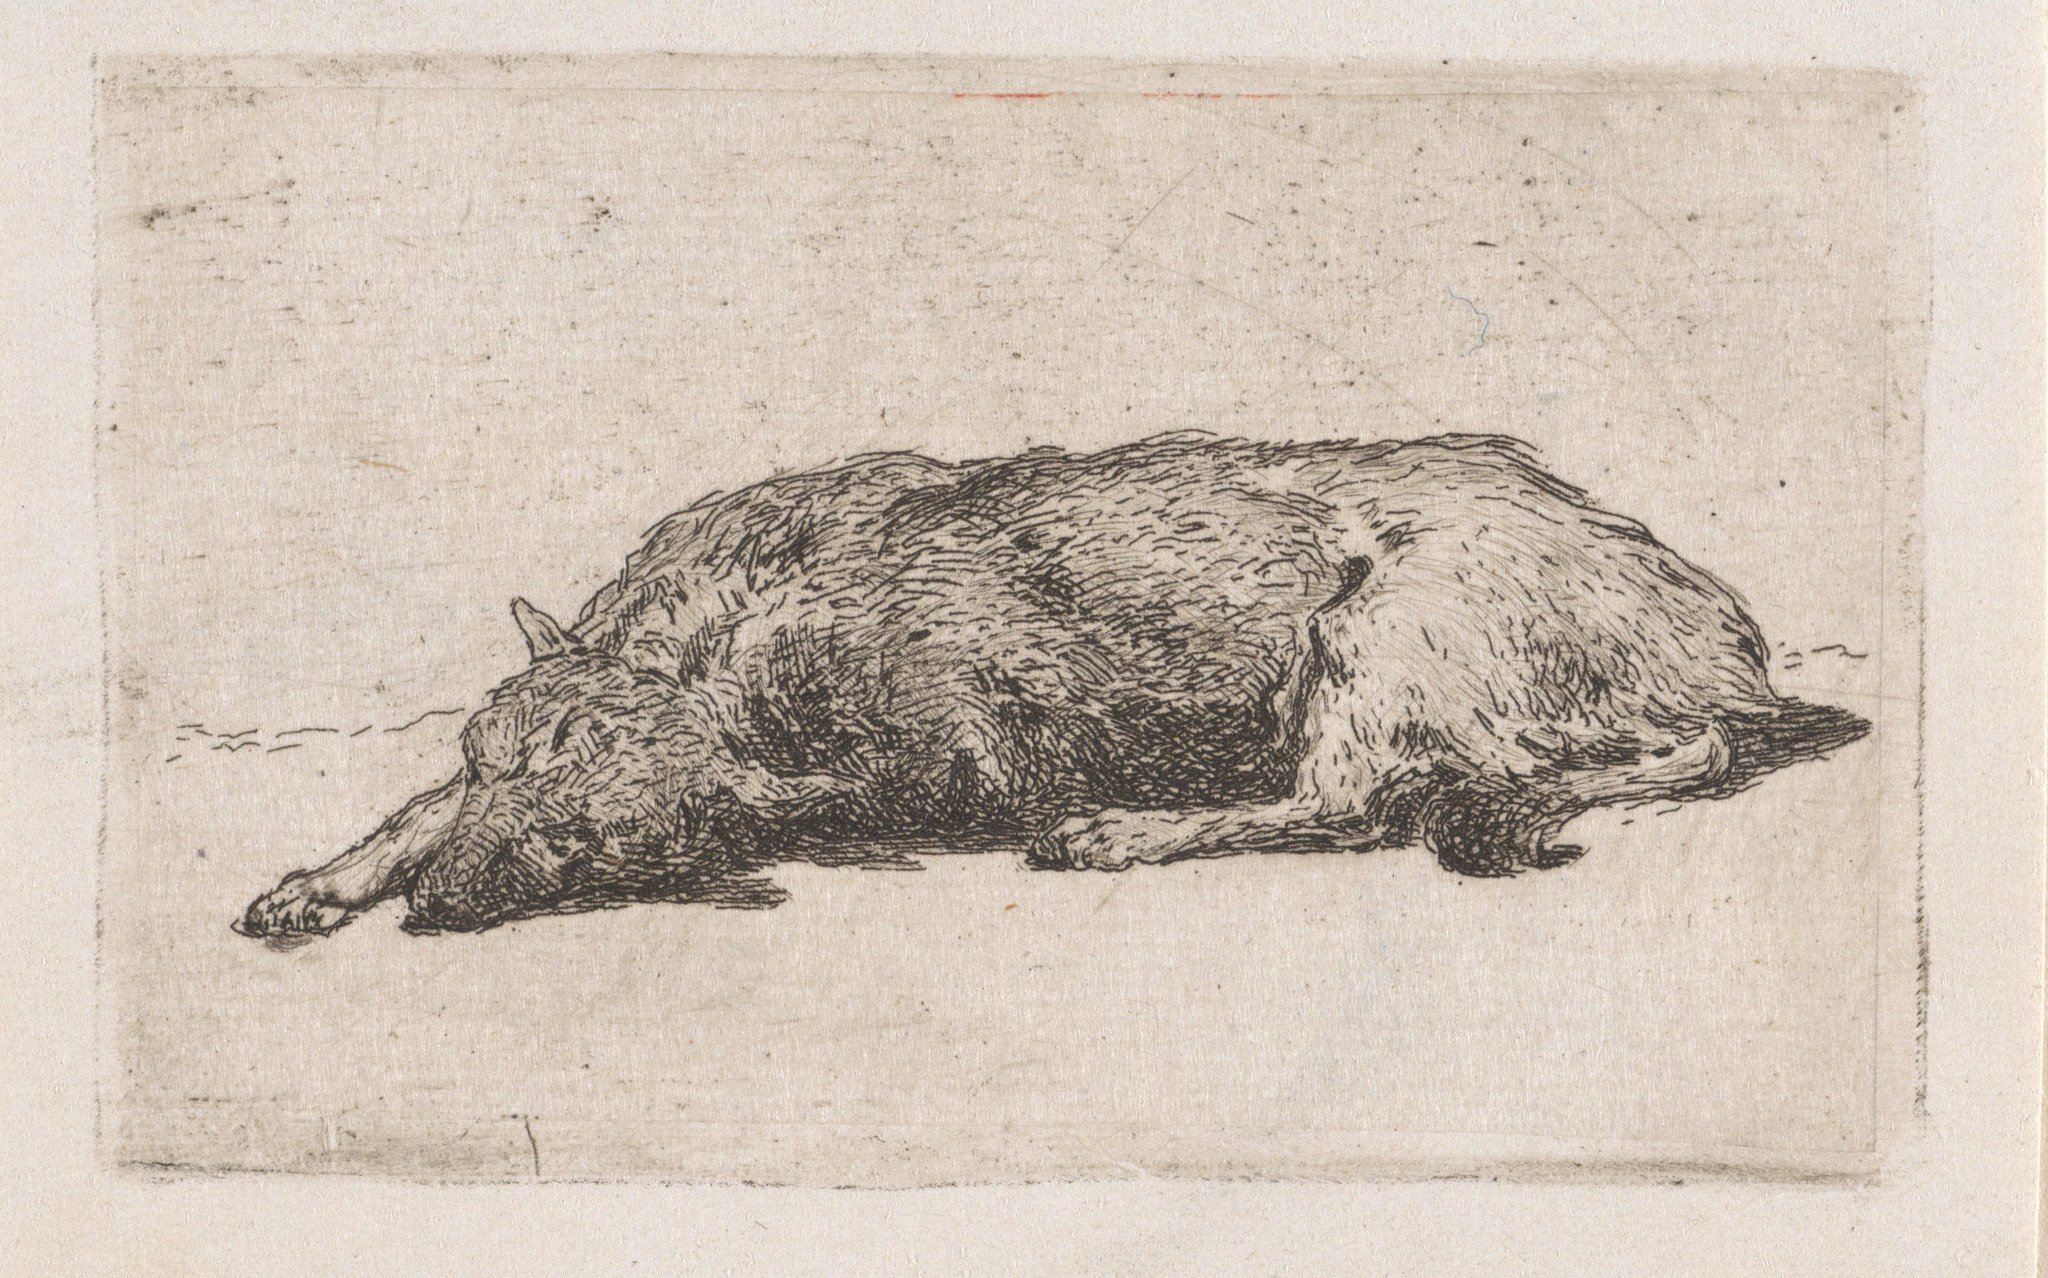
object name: print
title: Slapende hond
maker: jan weissenbruch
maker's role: painter, print maker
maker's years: 1822-1880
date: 1837-1880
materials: paper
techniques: etching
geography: the hague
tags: sleeping on the ground, dog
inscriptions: collector's mark: Lugt 2228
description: Een hond ligt op de grond te slapen. Zijn rechtervoorpoot heeft hij uitgestrekt.